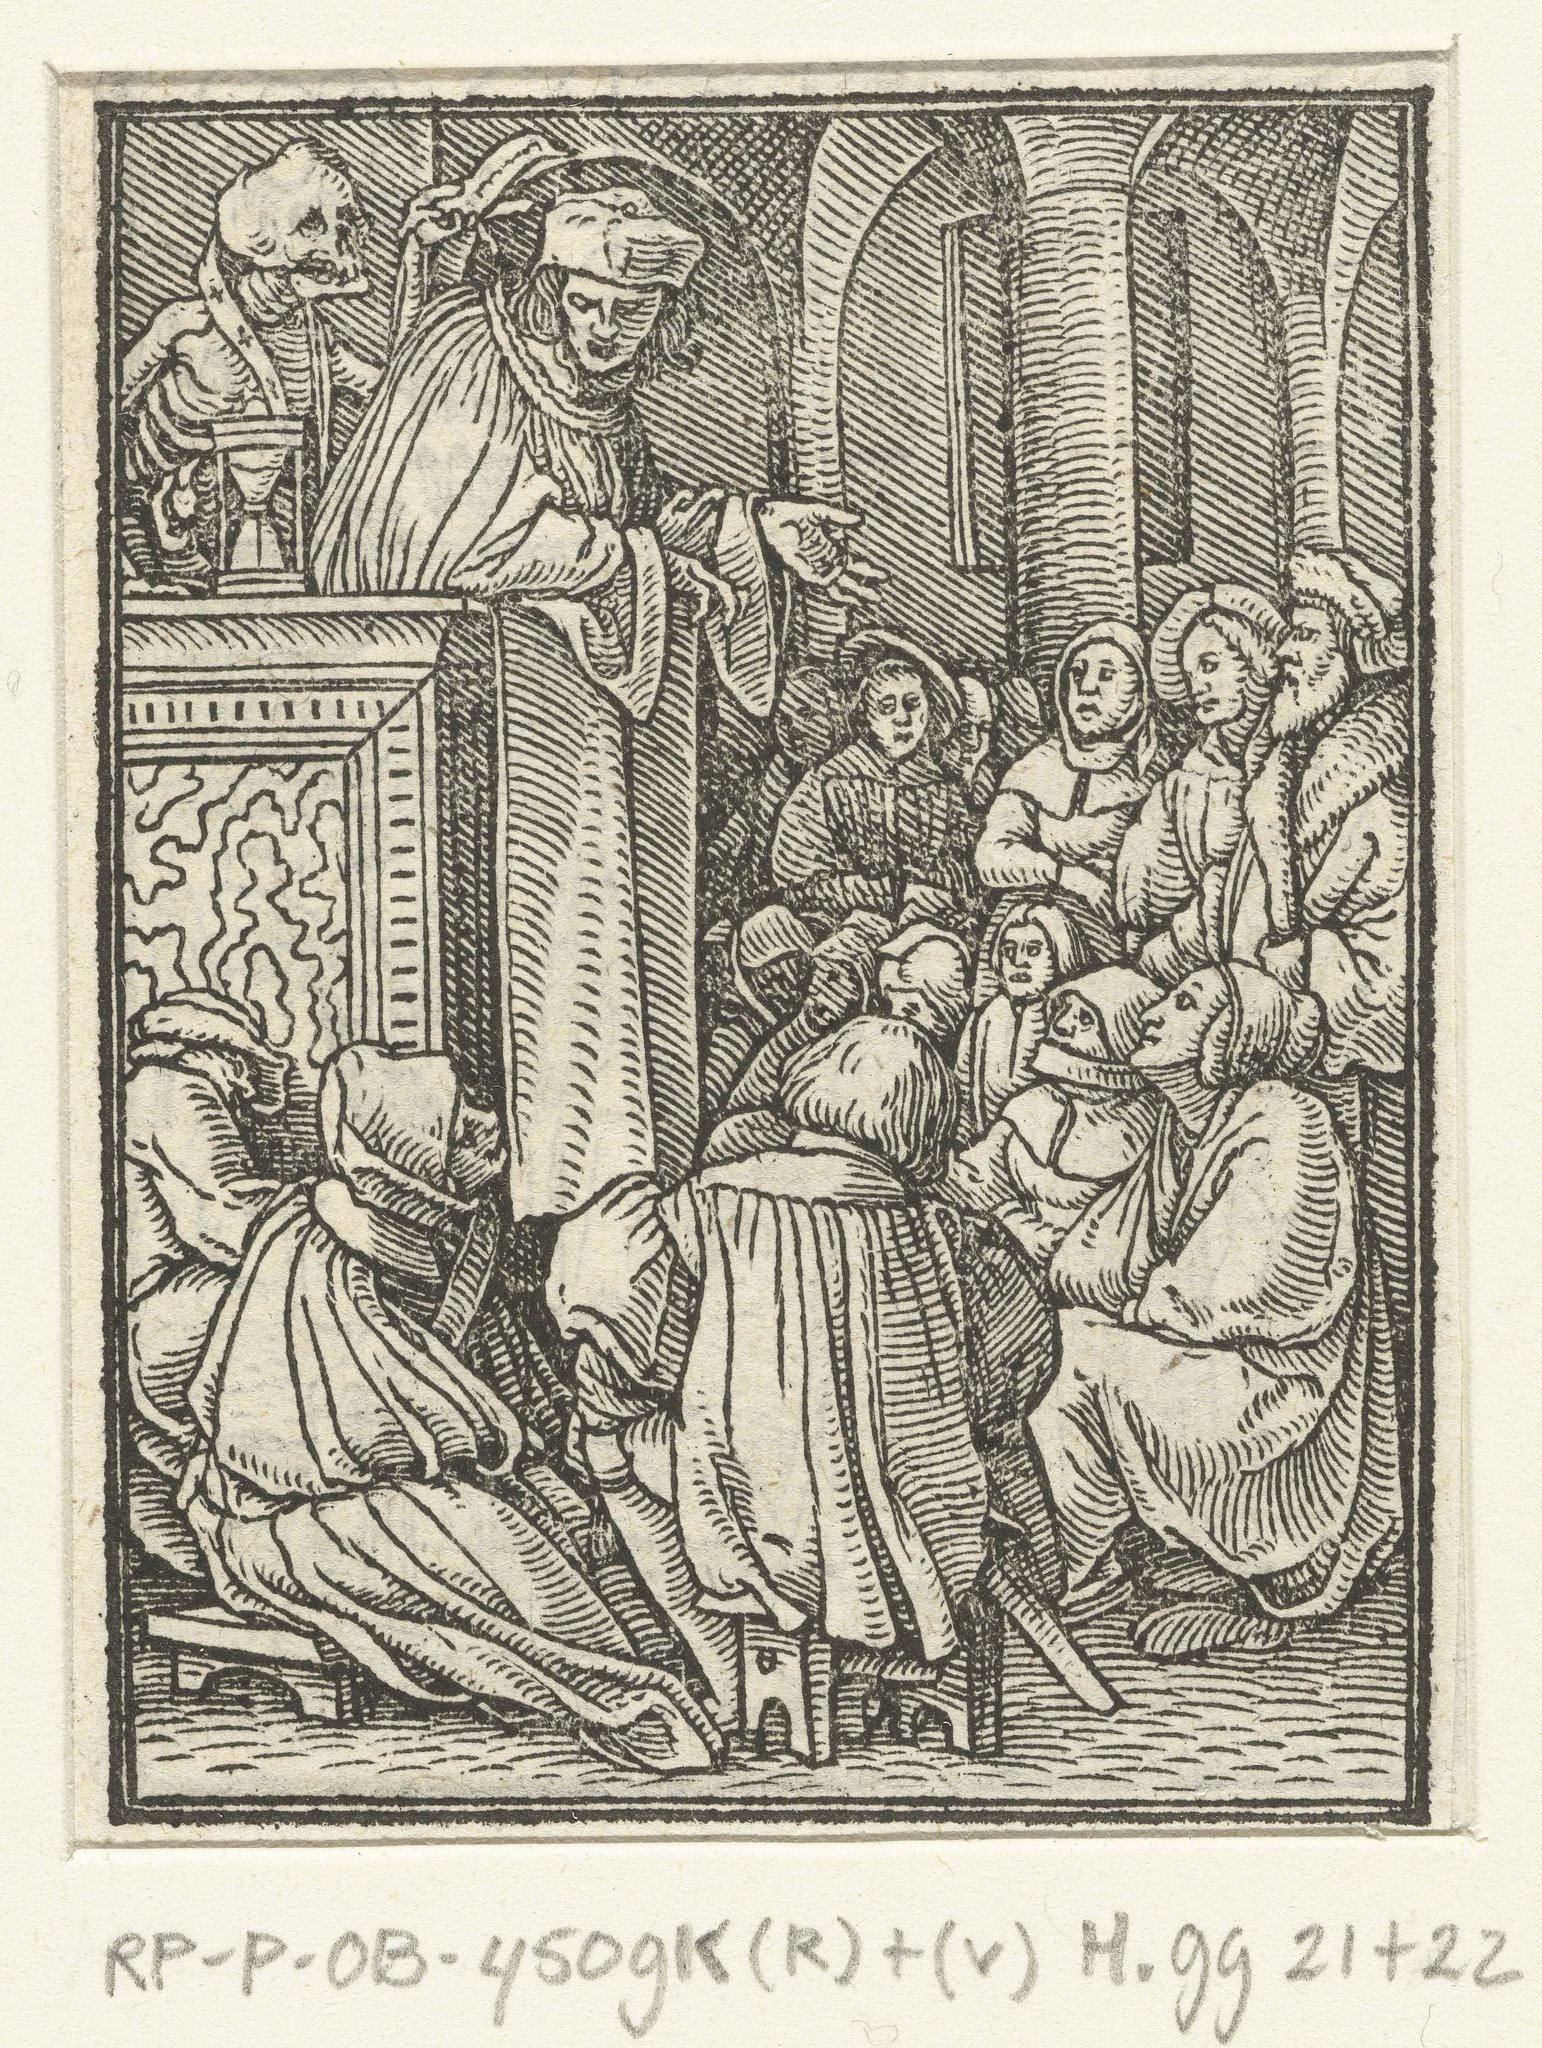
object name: print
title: Dodendans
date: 1524-1526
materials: paper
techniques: woodcut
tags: dance of death; death together with one or more human beings, functionaries and dignitaries ~ episcopal protestant churches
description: De houtblokken werden voor 1526 vervaardigd door Hans Lützelburg en pas in 1538 voor het eerst gebruikt als boekillustraties in: Les simulachres & historiees faces de la mort avtant elegamment pourtraictes que artificiellement imaginées... a Lyon, Soubsz l'escu de Coloigne, MDXXXVIII, (M. en G. Trechsel, voor F. Frellon in Lyon), 1538. Later verschenen nog andere uitgaven.